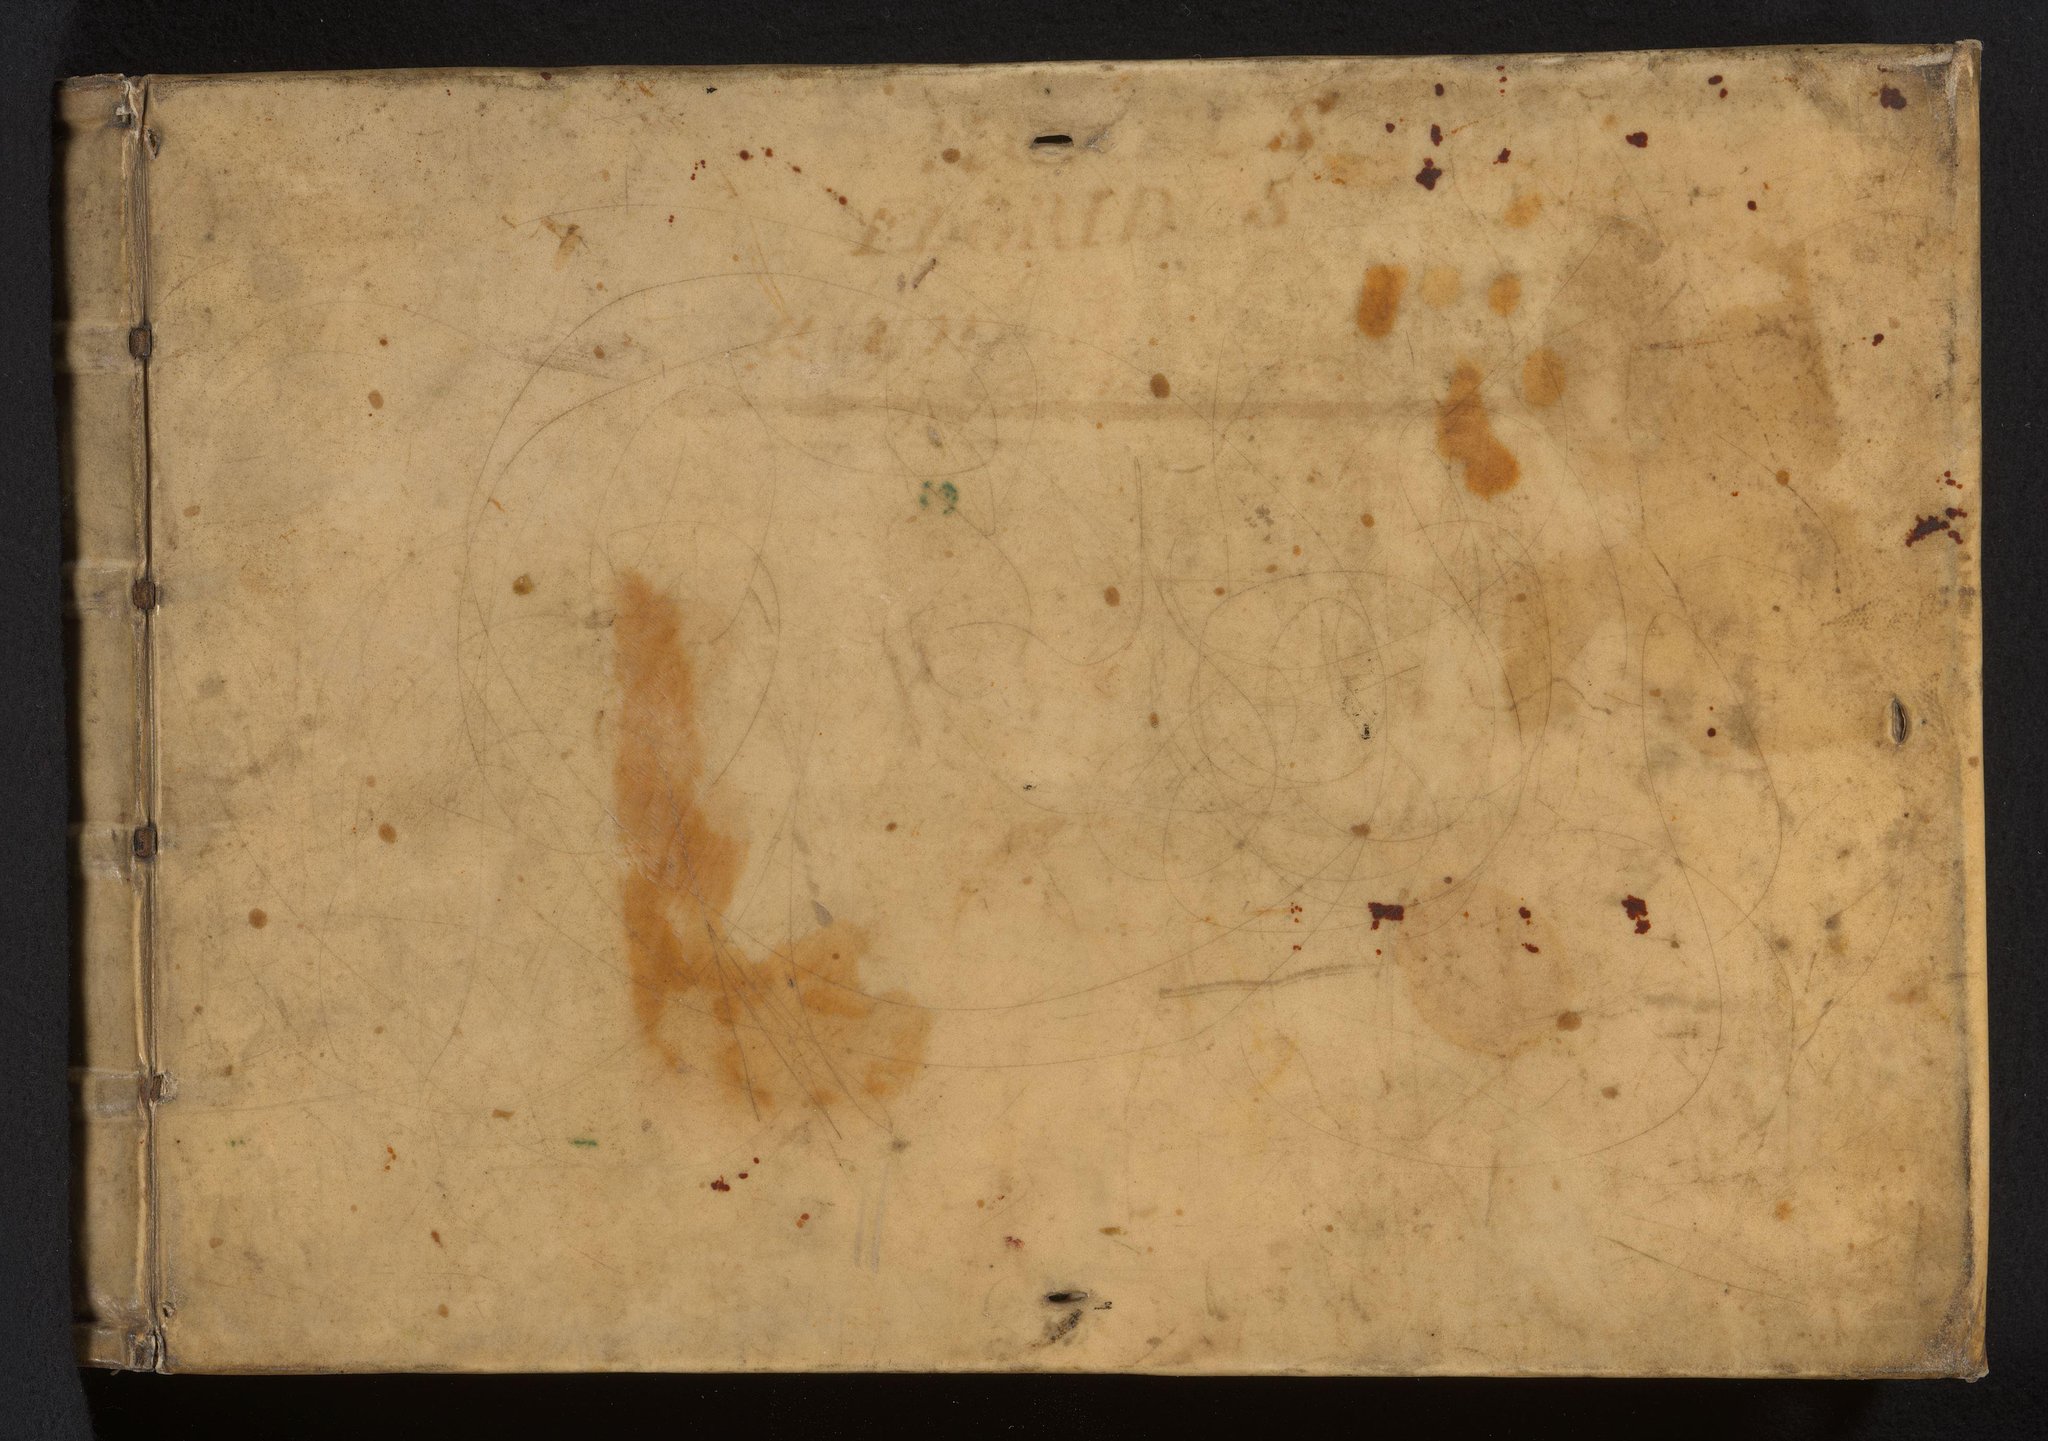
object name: book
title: Hortus floridus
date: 1617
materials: cardboard, paper, parchment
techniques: bookbinding, engraving, letterpress printing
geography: arnhem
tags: flowers, print, e.g.: engraving, etching, lithograph, book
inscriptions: collector's mark: ‘Koninklijk Oudheidkundig Genootschap - Bibliotheek’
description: Latijnse editie van Crispijn de Passes 'Hortus floridus', met daarin vijf delen. Het eerste deel bevat een titelprent, twee pagina's tekst, een pagina met twee lofdichten op De Passe, op het verso daarvan een lijst van de eerste 41 prenten. Dan volgt een prent met daarop een tuin in vogelvluchtperspectief, voor de daadwerkelijke serie van 53 prenten, ieder met op het verso de beschrijving van de volgende prent. Het tweede deel is getiteld 'Aestas horti floridi' en bestaat uit een titelpagina, een tuingezicht en twintig prenten. Net als in het voorgaande deel op het verso van elke prent de beschrijving van de volgende. Het derde deel ('Autumnus horti floridi rariores autumni flores summa industria et labore') bevat naast de titelpagina en het tuingezicht ook een prent getiteld 'Epigramma' voor de reeks van 27 prenten. Het vierde deel, 'Hortus floridus hyemalis', bevat een titelpagina, gezicht op een tuin en twaalf prenten met beschrijving op het verso van de voorgaande prent. Het boek eindigt met het vijfde deel: 'Altera pars hori floridi in qua praeter flores'. Dit deel bevat een titelpagina, een tweede titel en 61 prenten, elk met een beschrijving op het verso van de voorgaande prent. Alle beschrijvingen en teksten in het boek zijn in het Latijn. Naast de prenten is de tekst nog gedecoreerd met een groot aantal initialen in houtsnede.